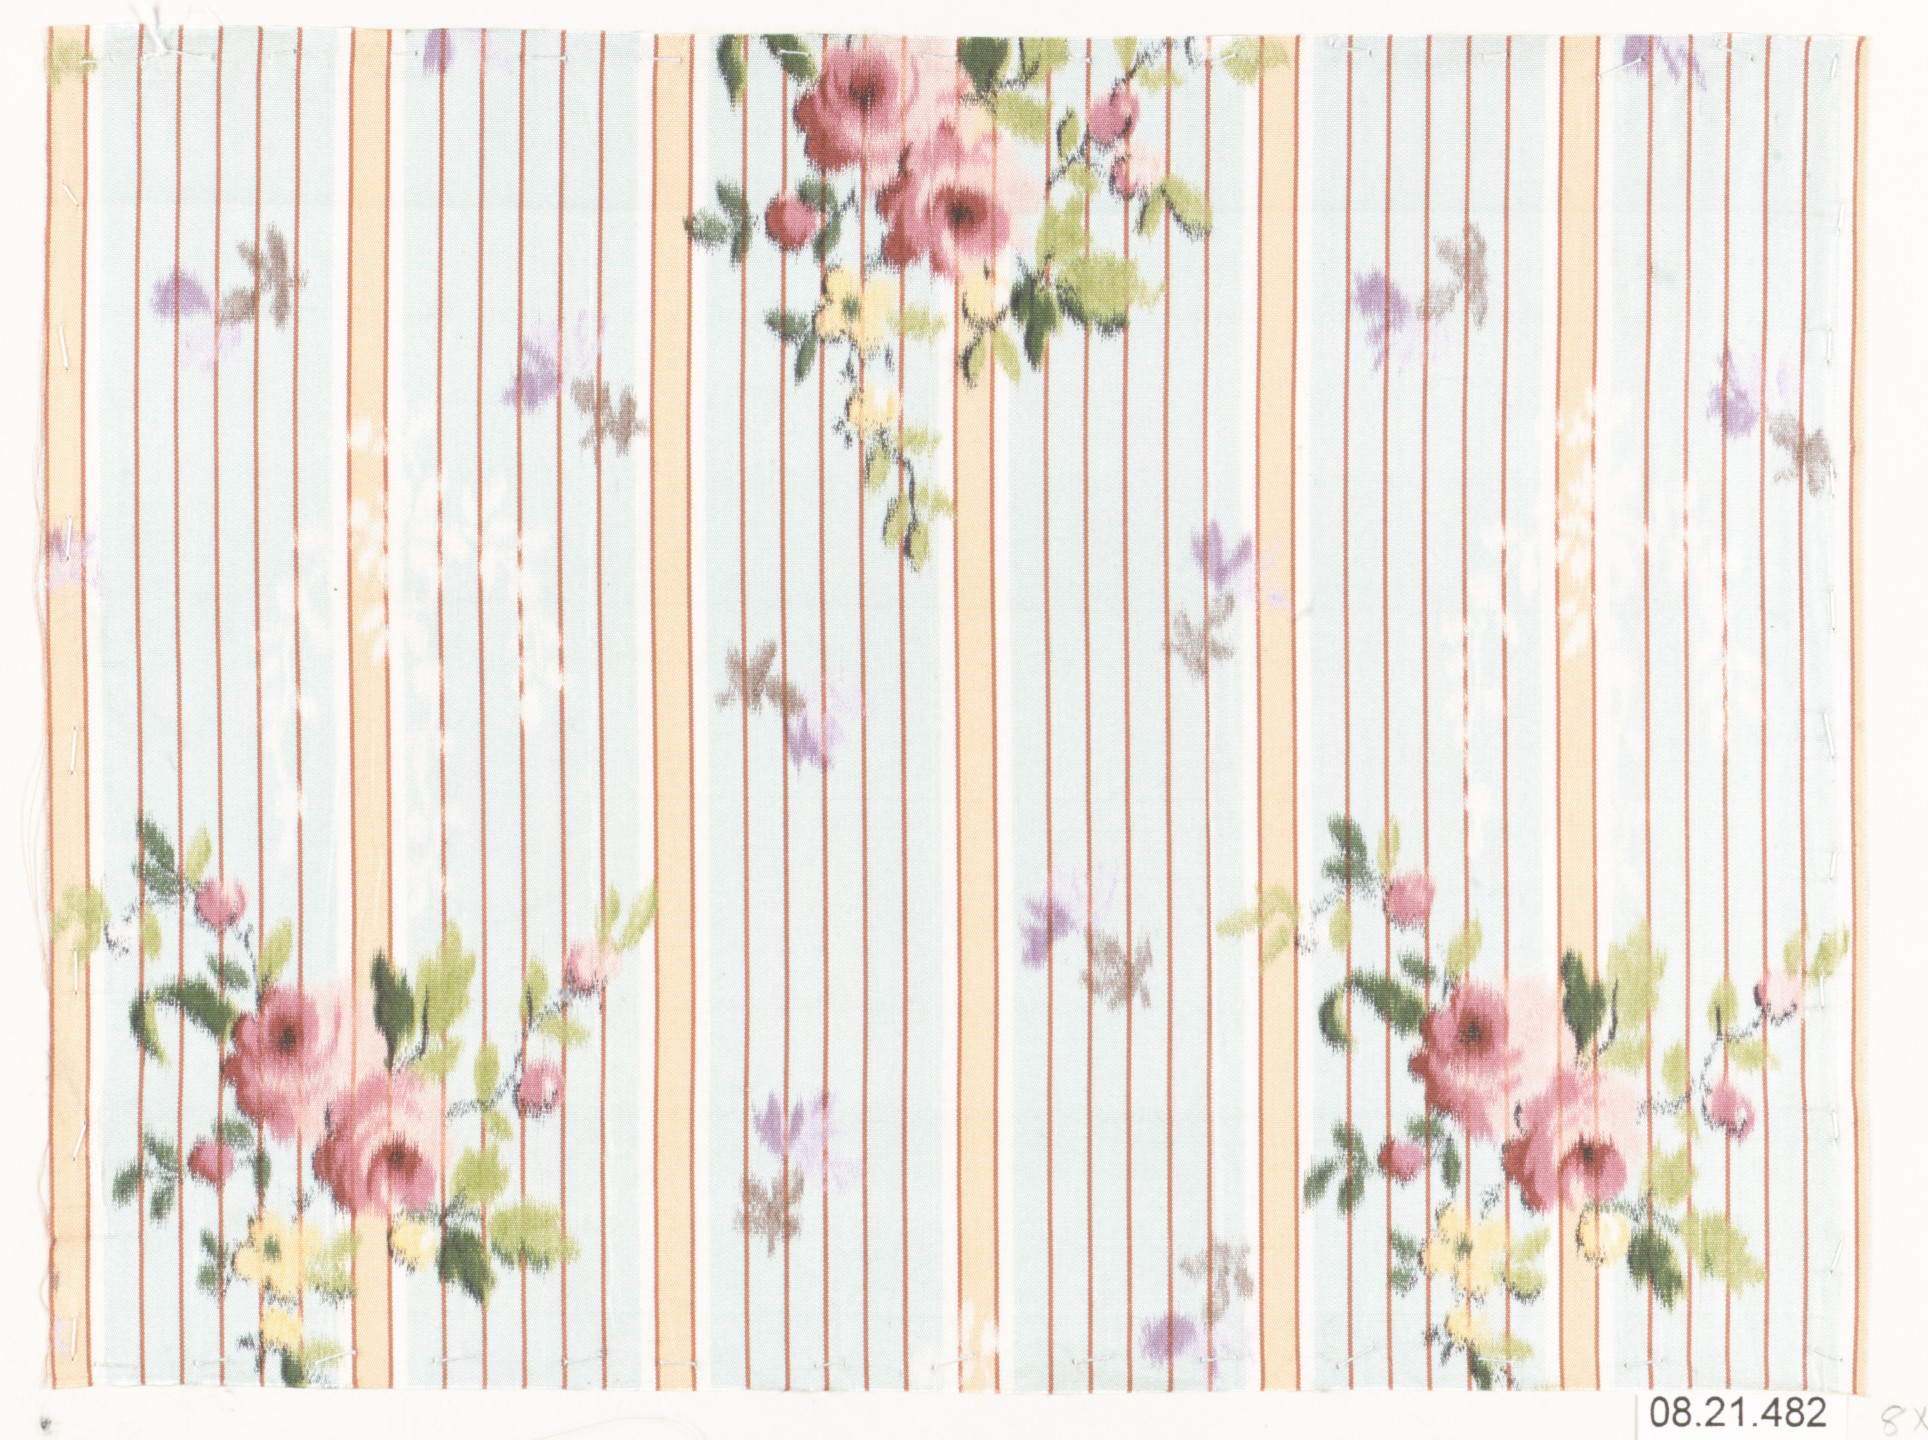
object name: textile sample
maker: Anonymous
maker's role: designer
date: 1900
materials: silk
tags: flowers